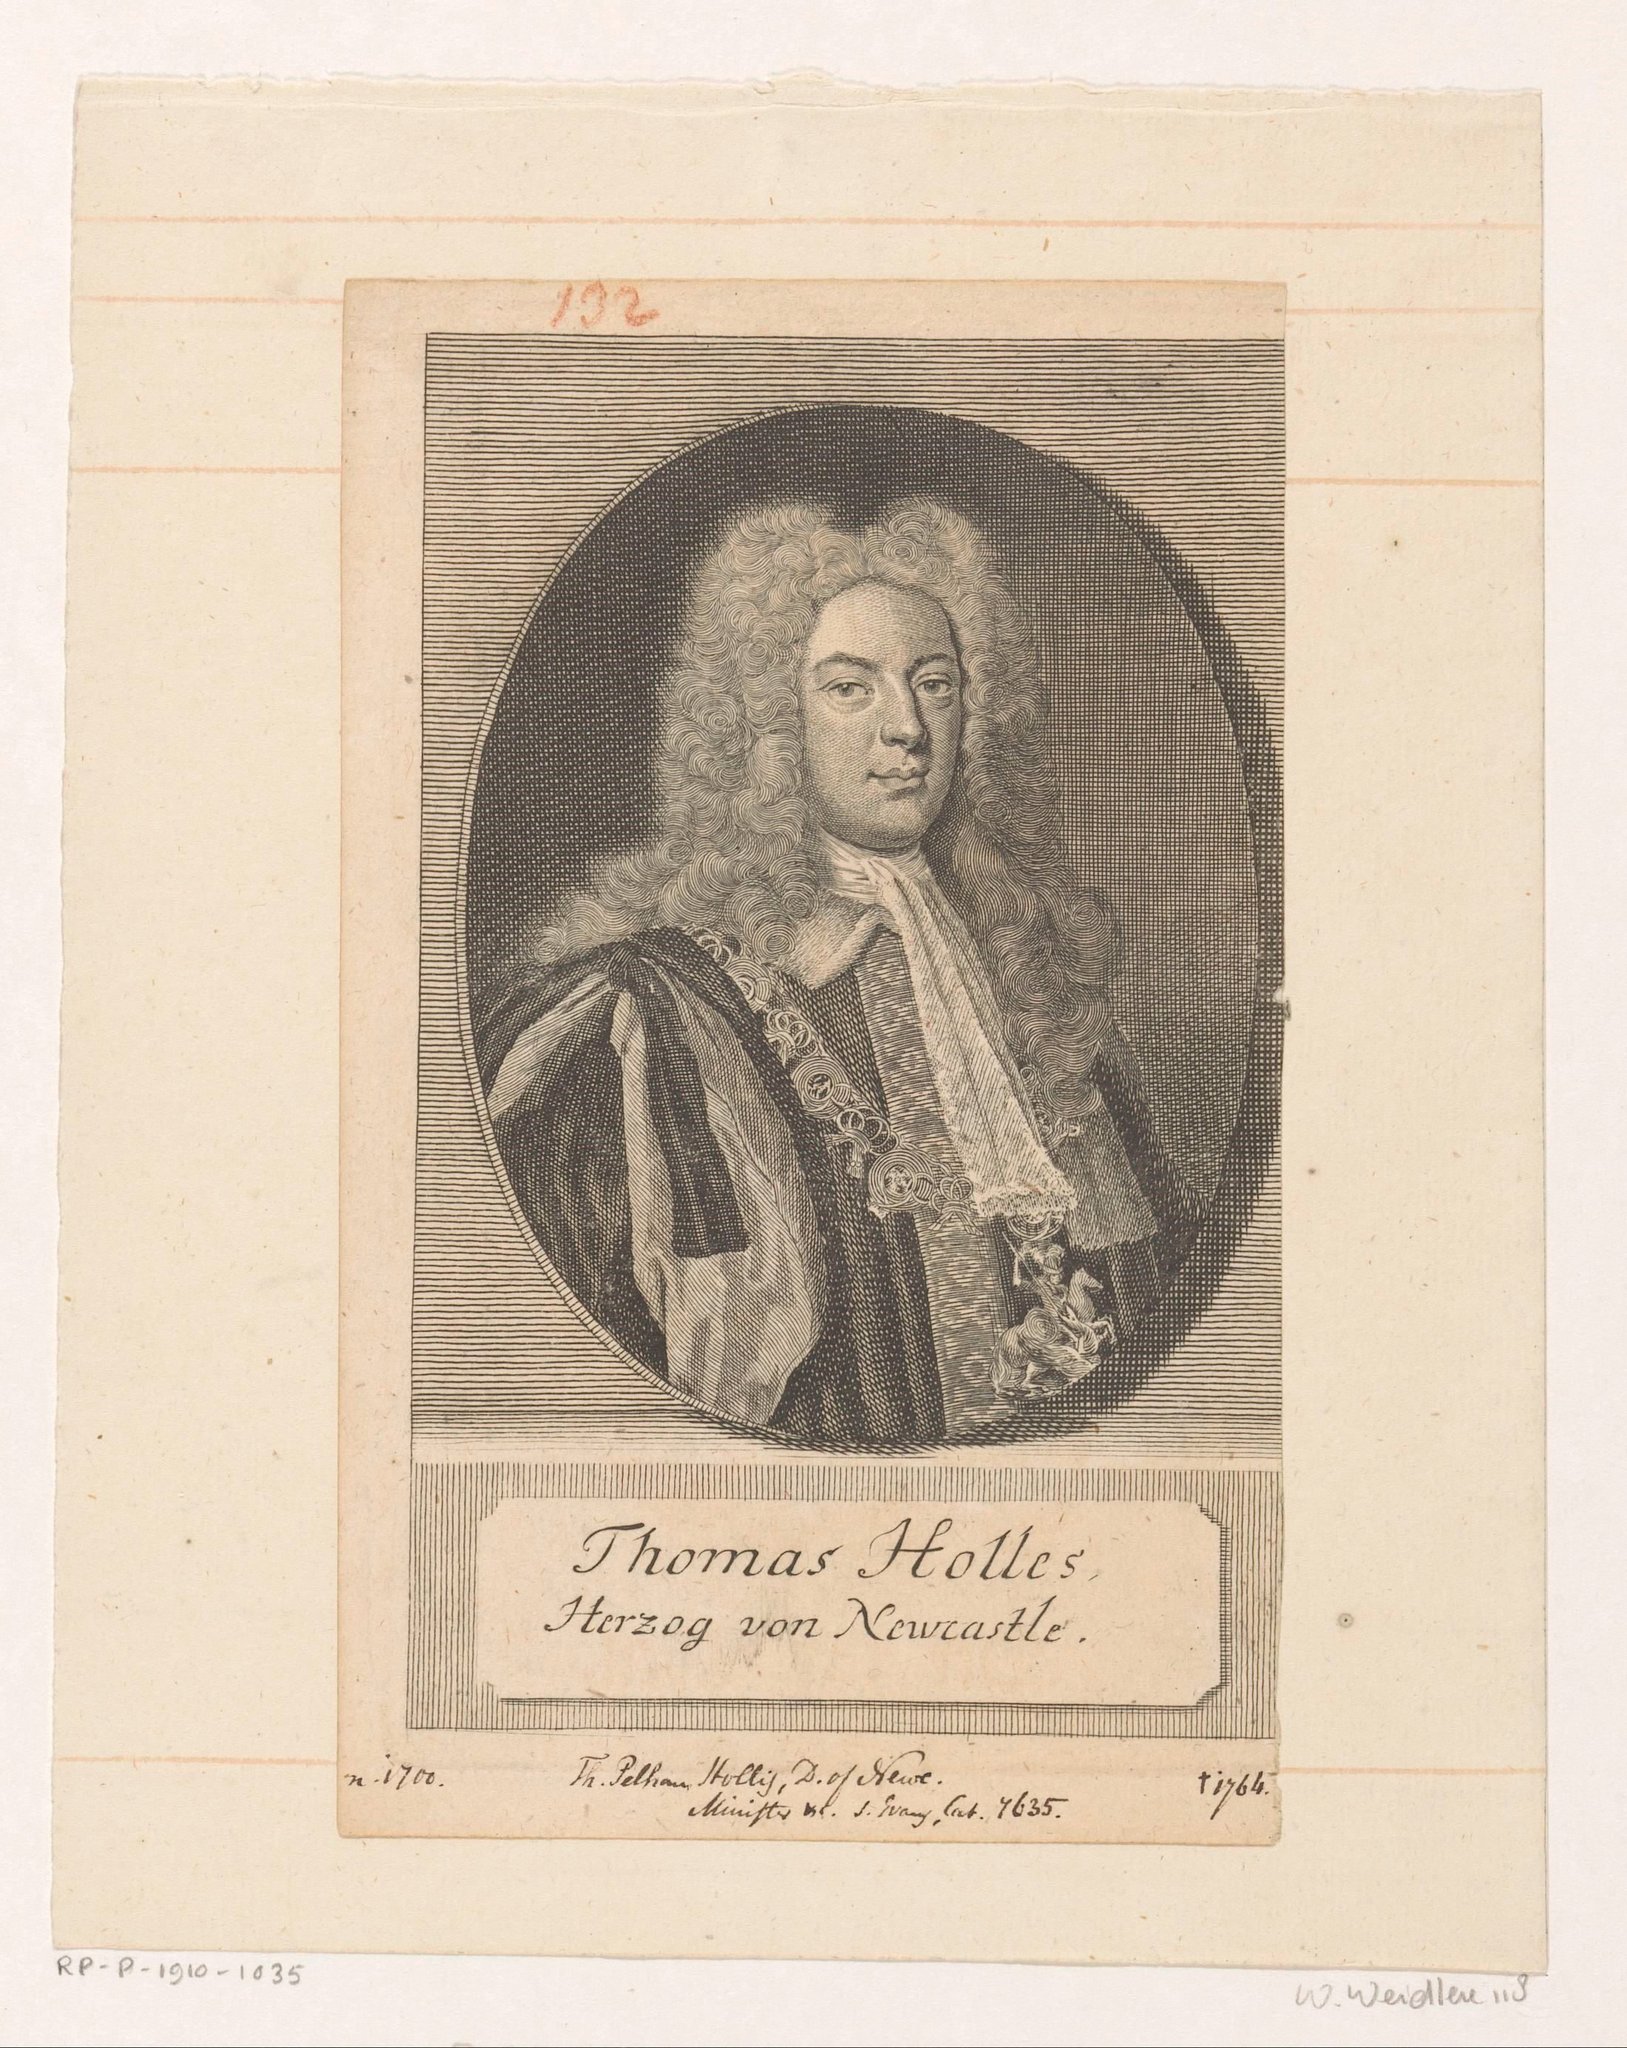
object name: print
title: Portret van Thomas Pelham-Holles, 1st Duke of Newcastle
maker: martin bernigeroth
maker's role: print maker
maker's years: 1670-1733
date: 1729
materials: paper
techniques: engraving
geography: leipzig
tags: london, historical persons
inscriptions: collector's mark: Lugt 2228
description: Prent ook gebruikt in: Die Europäische Fama, Welche den gegenwärtigen Zustand der vornehmsten Höfe entdecket. dl. 321. Leipzig: Gleditsch, 1729.